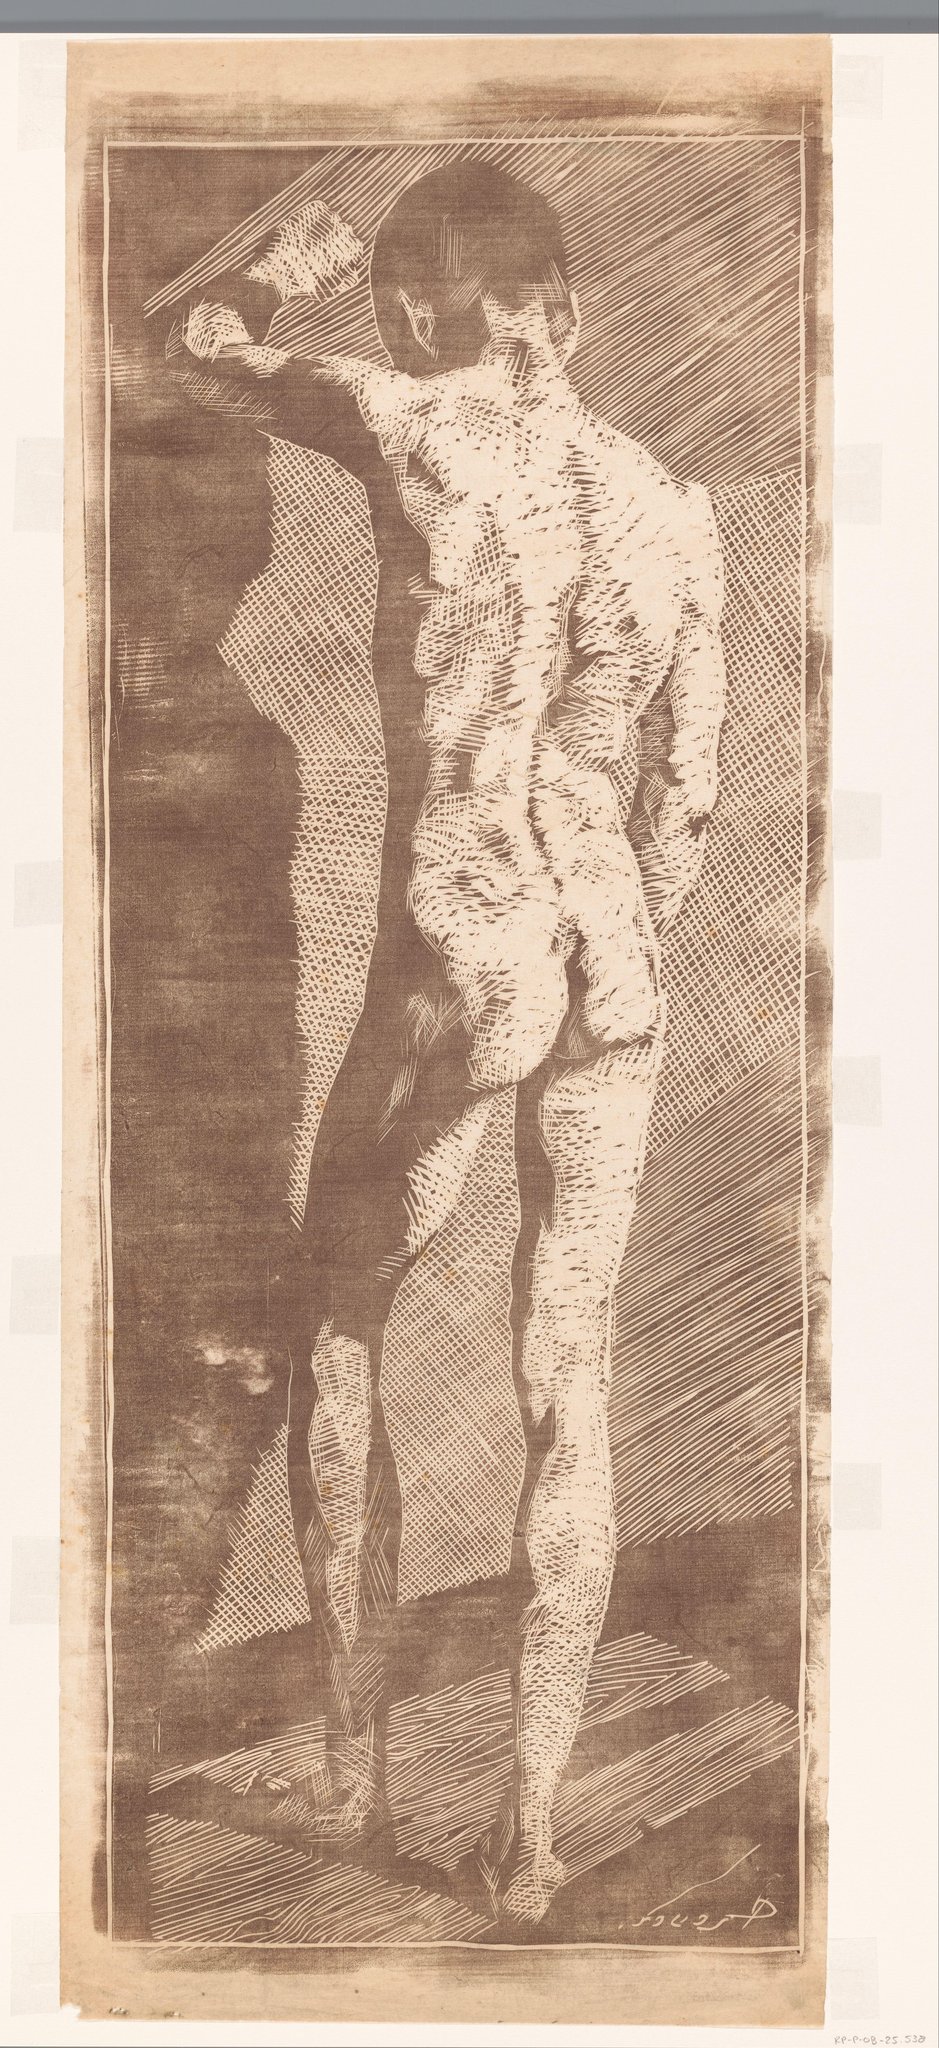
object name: print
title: Staande jongen, op de rug gezien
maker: reijer stolk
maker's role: draughtsman, print maker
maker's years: 1896-1945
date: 1906-1945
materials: paper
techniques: woodcut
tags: boy (child between toddler and youth), standing figure (+ back view)